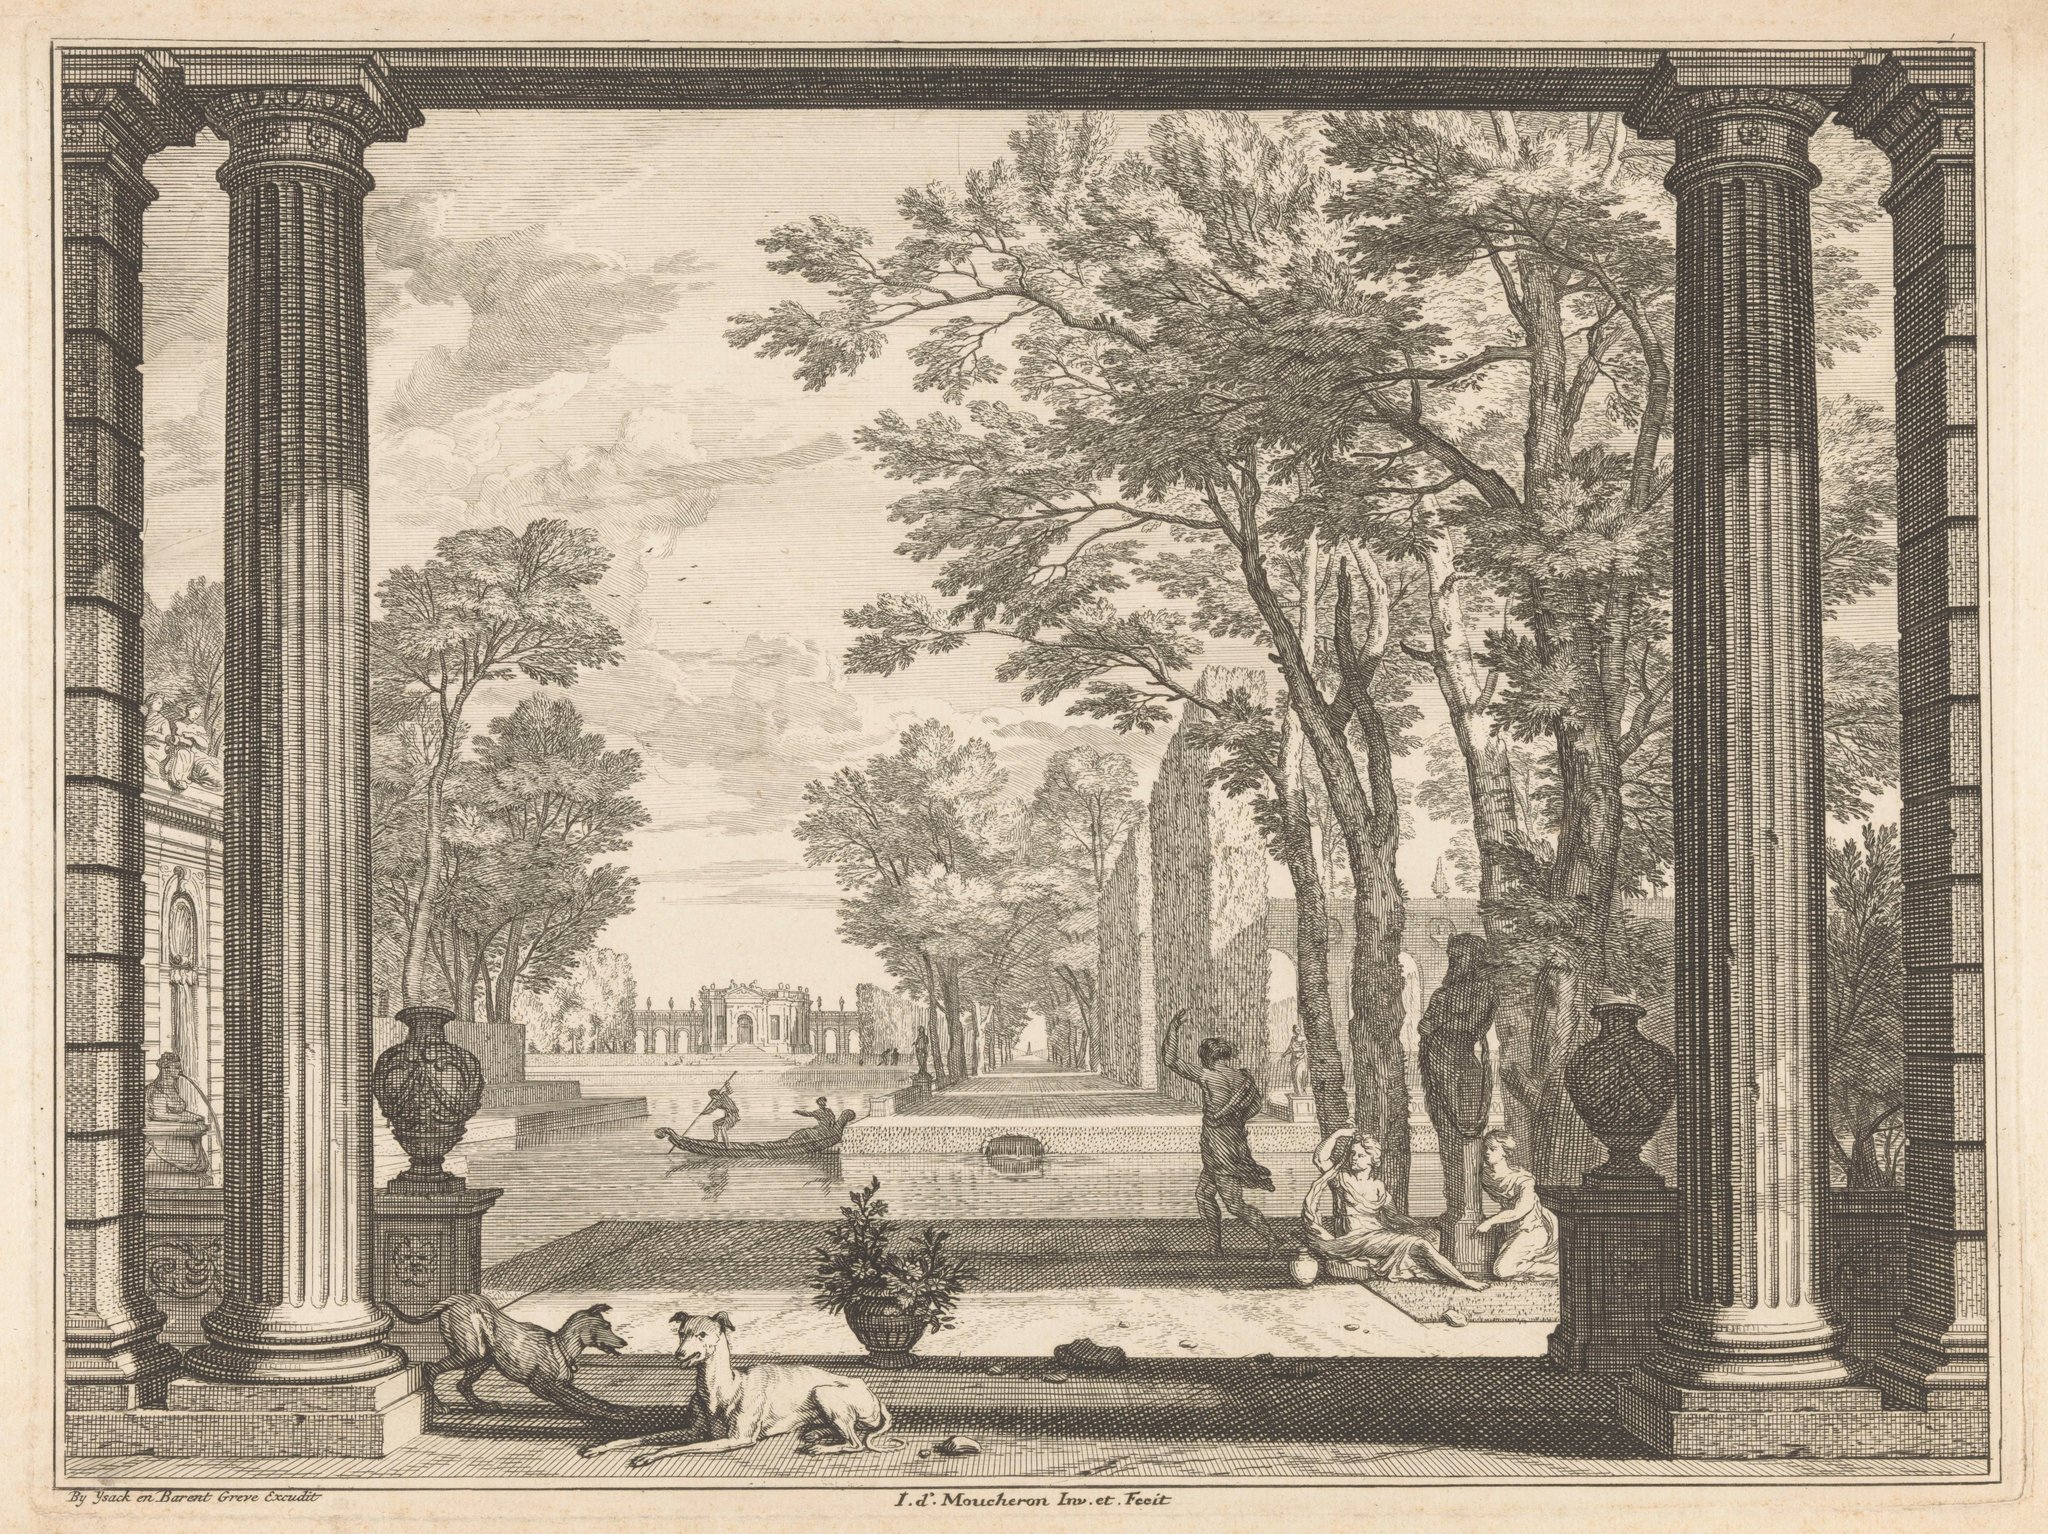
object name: print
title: Parklandschap met twee honden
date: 1677-1744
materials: paper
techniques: engraving, etching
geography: amsterdam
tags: column, pillar ~ architecture, french or architectonic garden; formal garden, gondola, dog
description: Zicht in een tuin geflankeerd door zuilen. Op de voorgrond twee honden. Op de achtergrond zittende figuren en een figuur op de rug gezien bij een waterbassin.